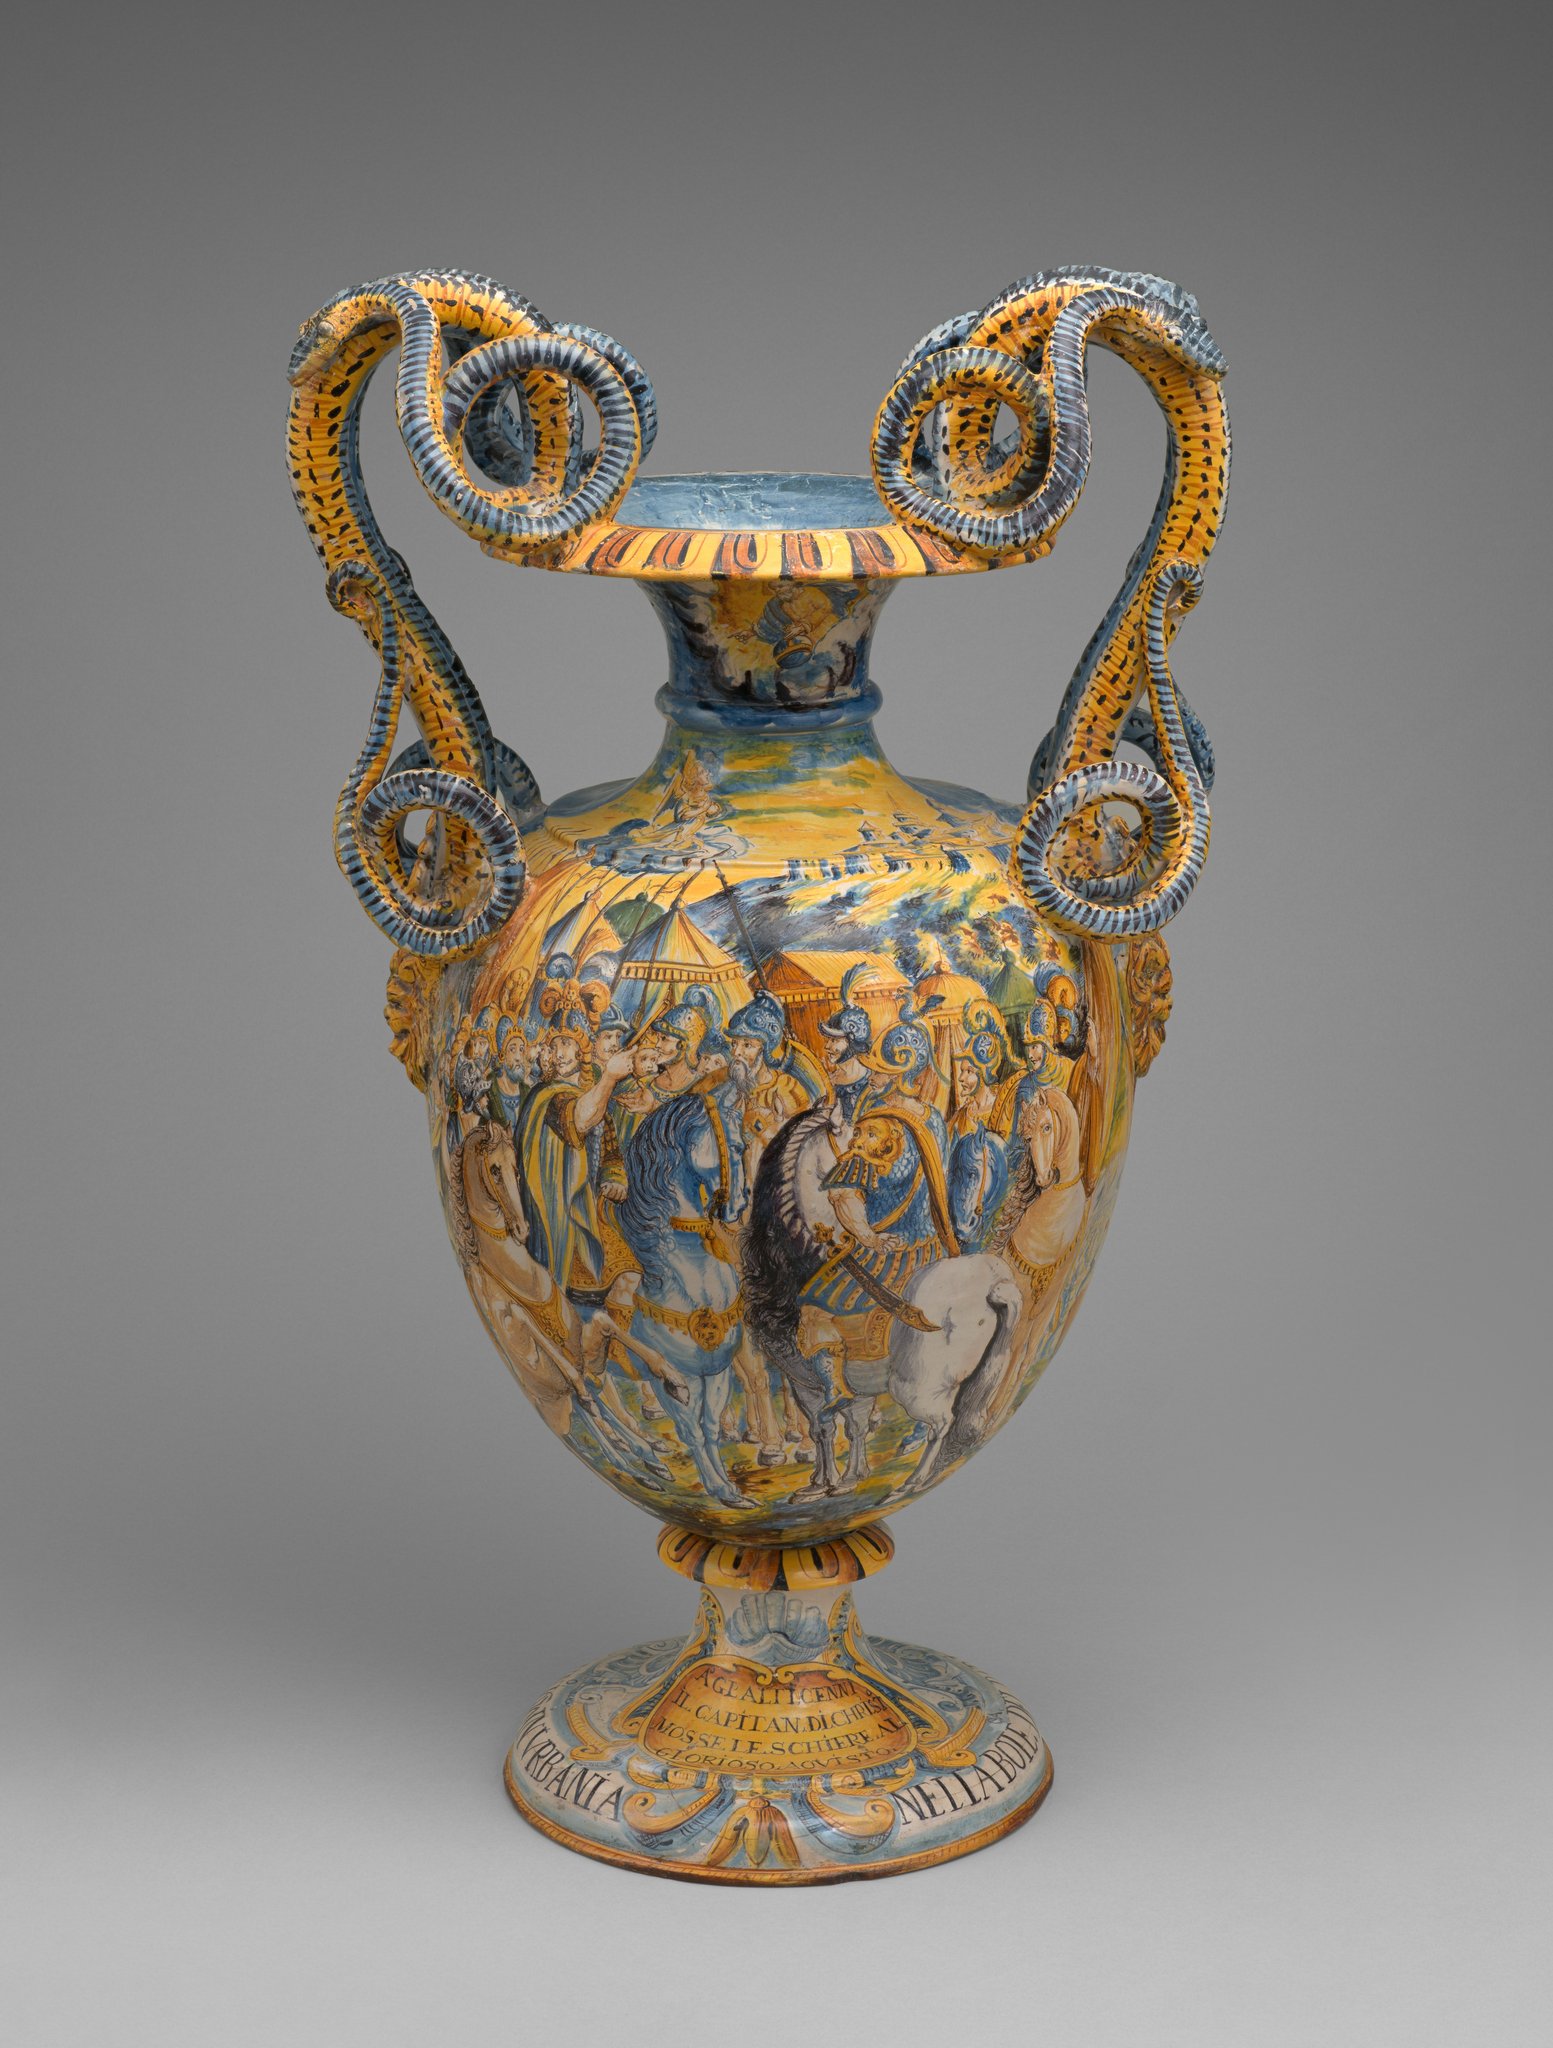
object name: vase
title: A pair of monumental vases with scenes from "Jerusalem Delivered"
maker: papi workshop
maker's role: maker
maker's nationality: italian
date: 1670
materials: earthenware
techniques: maiolica, glazing